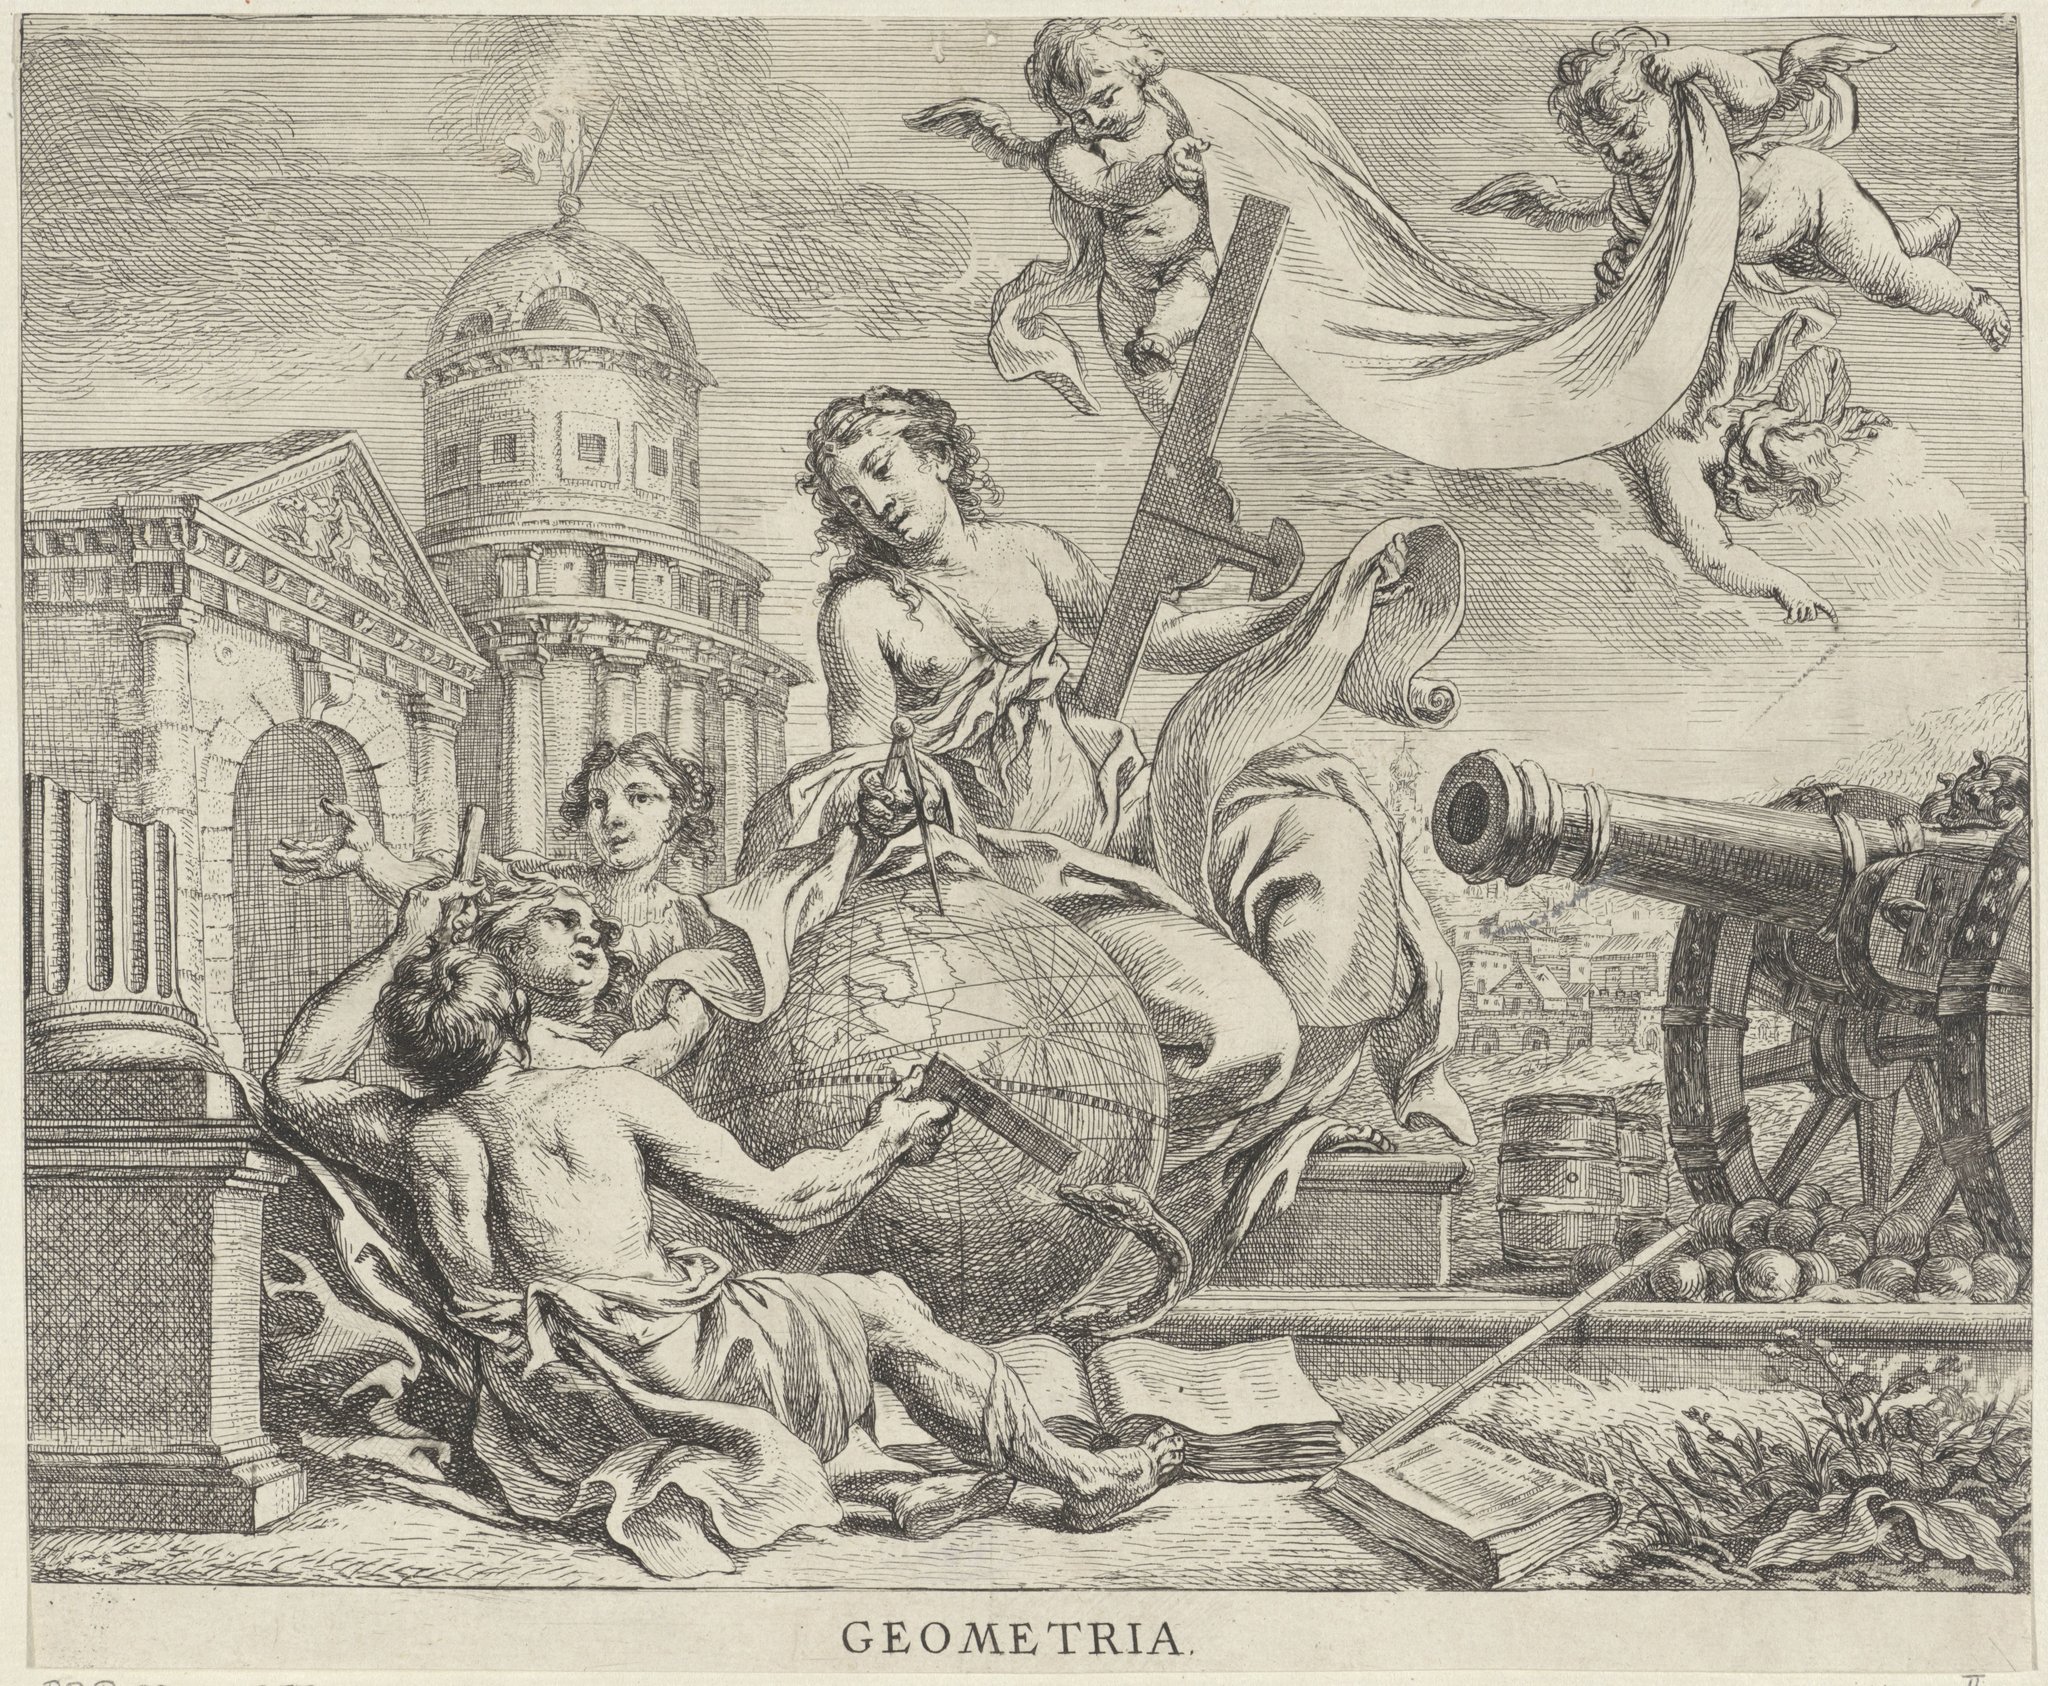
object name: print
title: De zeven vrije kunsten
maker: cornelis schut (i)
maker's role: draughtsman, print maker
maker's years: 1597-1655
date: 1618-1655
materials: paper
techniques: engraving, etching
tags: snakes, 'geometria' (~ quadrivium); 'geometria' (ripa), measuring-instruments, globe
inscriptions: collector's mark: Lugt 2228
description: Tegen een achtergrond van klassieke gebouwen meet Geometria een wereldbol met een passer. Op de grond zit een man die, net als Geometria, meetinstrumenten in zijn handen houdt. Een vrouw gebaart richting de gebouwen op de achtergrond. Links staat een kanon, op de grond liggen boeken en een duimstok. Een slang krult zich rondom de wereldbol.